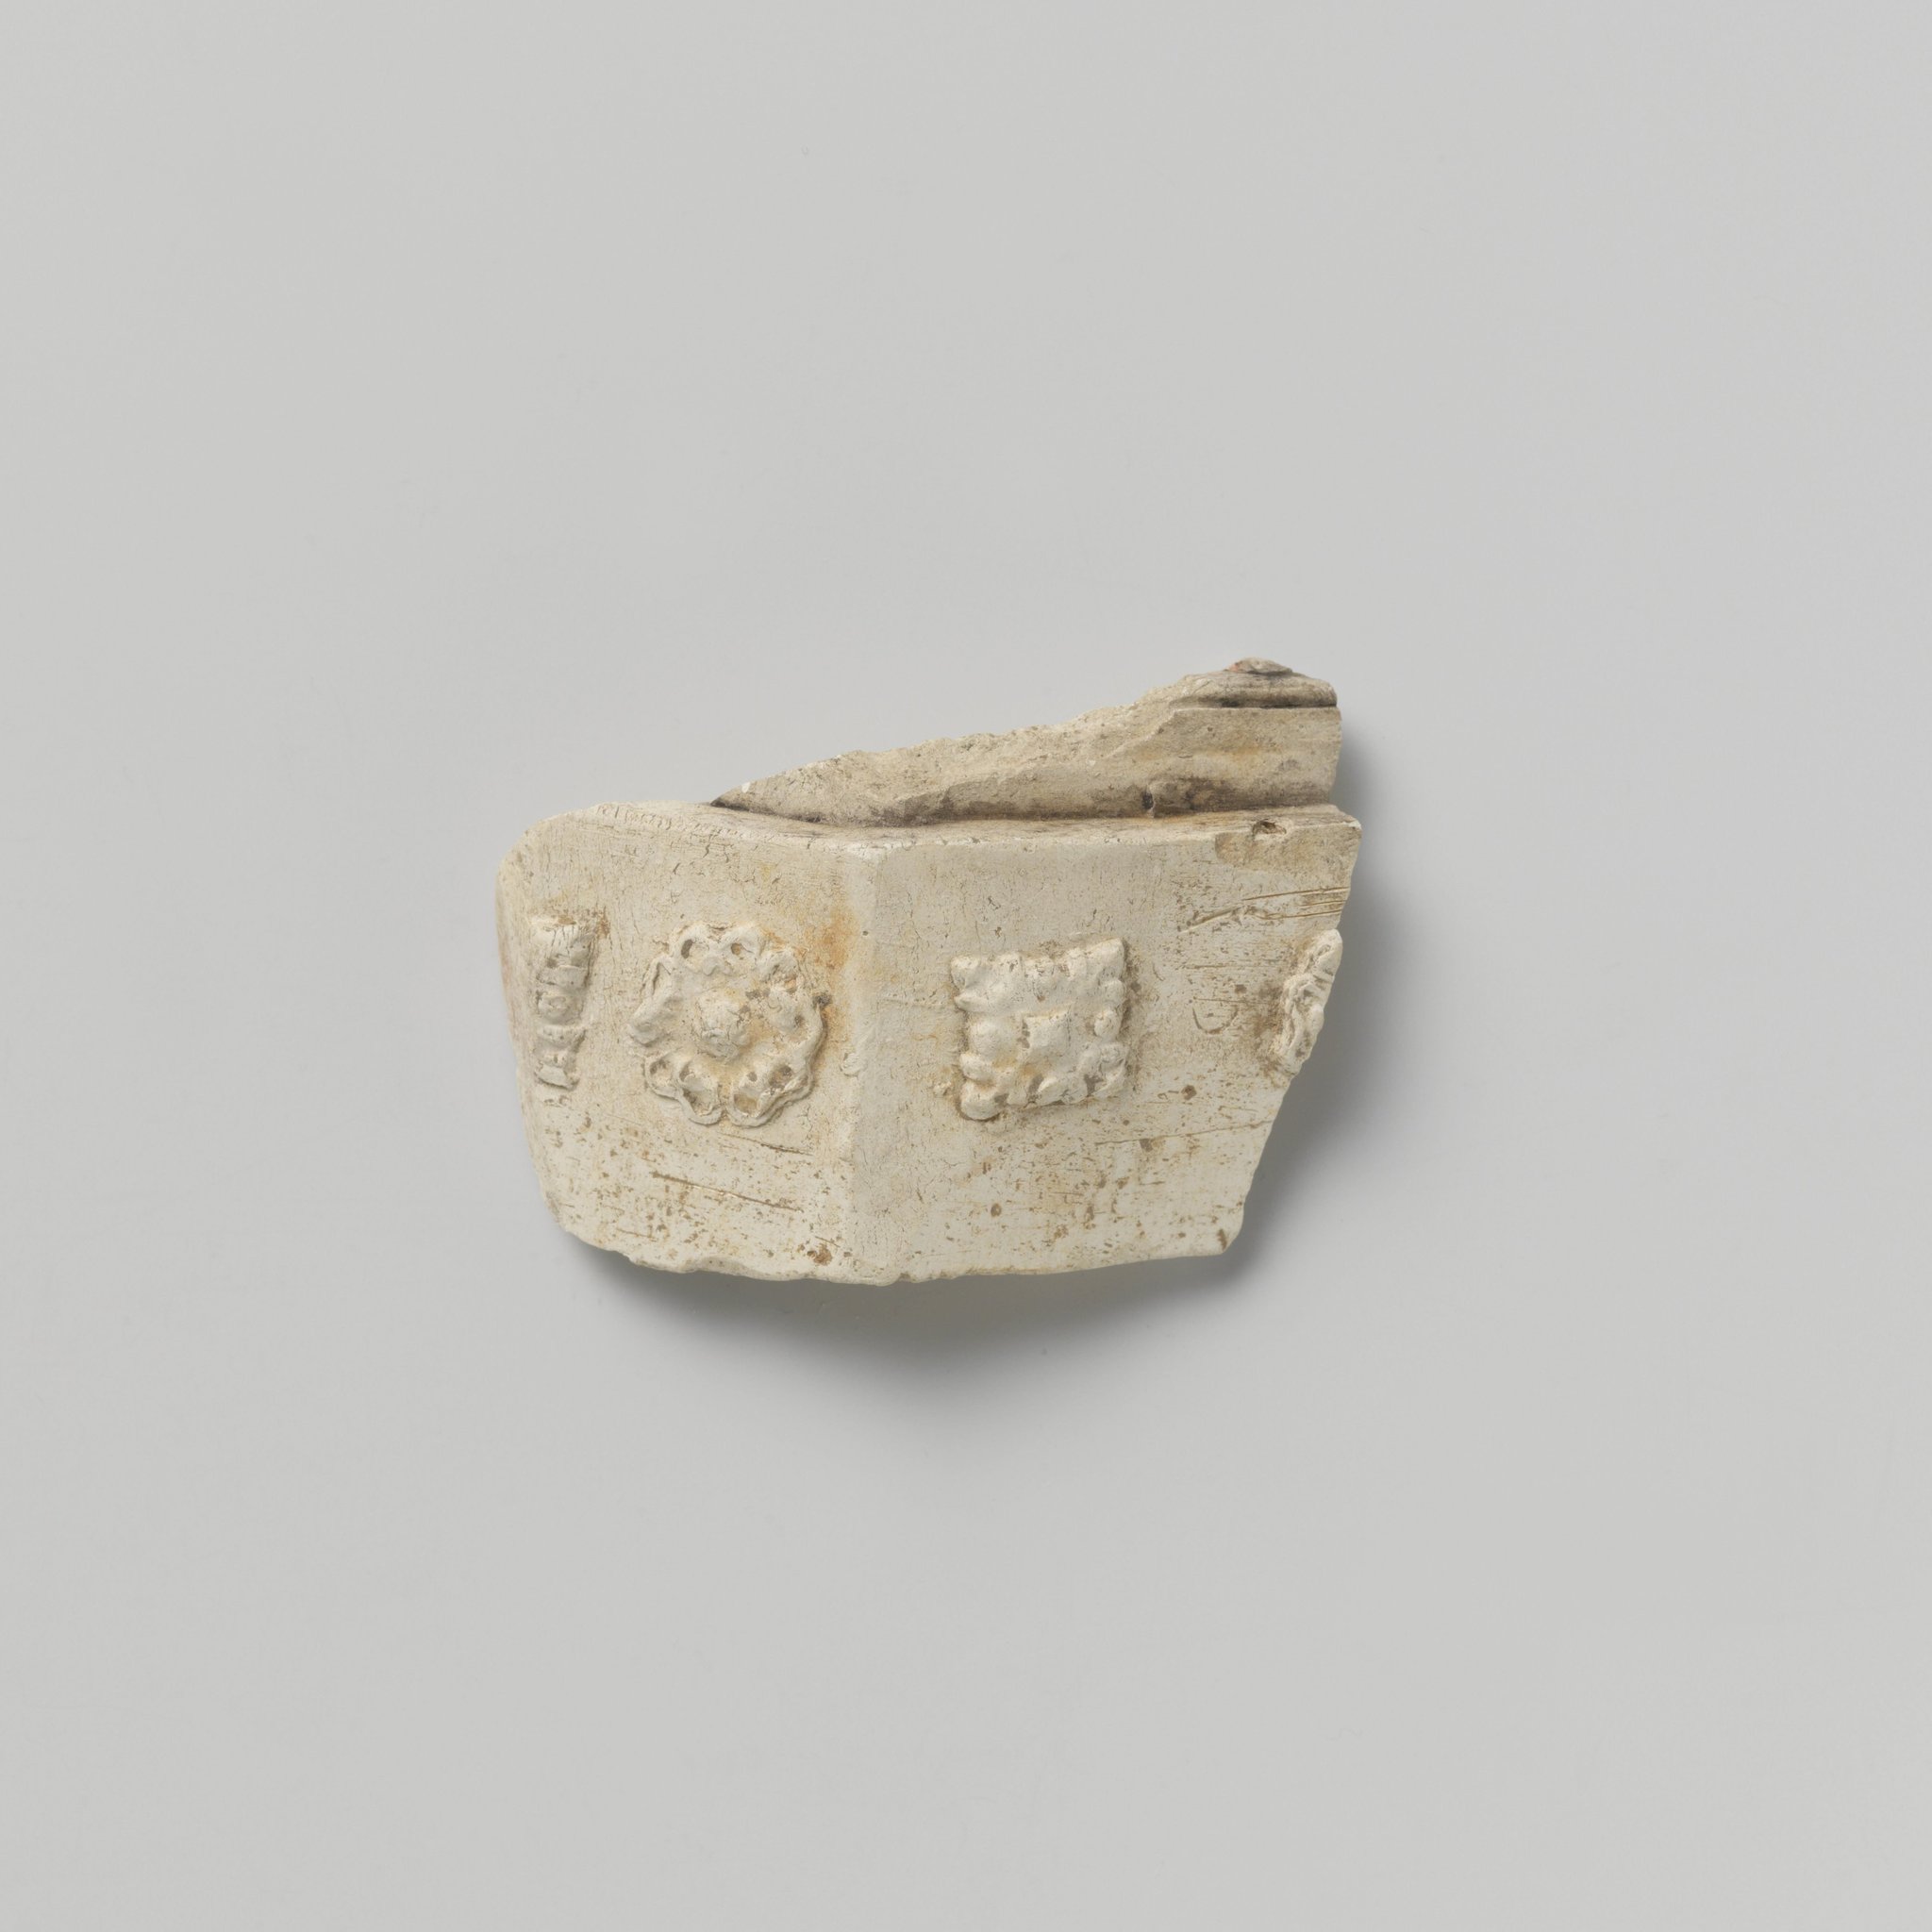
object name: sculpture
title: Fragment of a Utrecht Socle Type, with Ornamental Rosettes on the Plinth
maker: Anonymous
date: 1425-1550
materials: clay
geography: utrecht